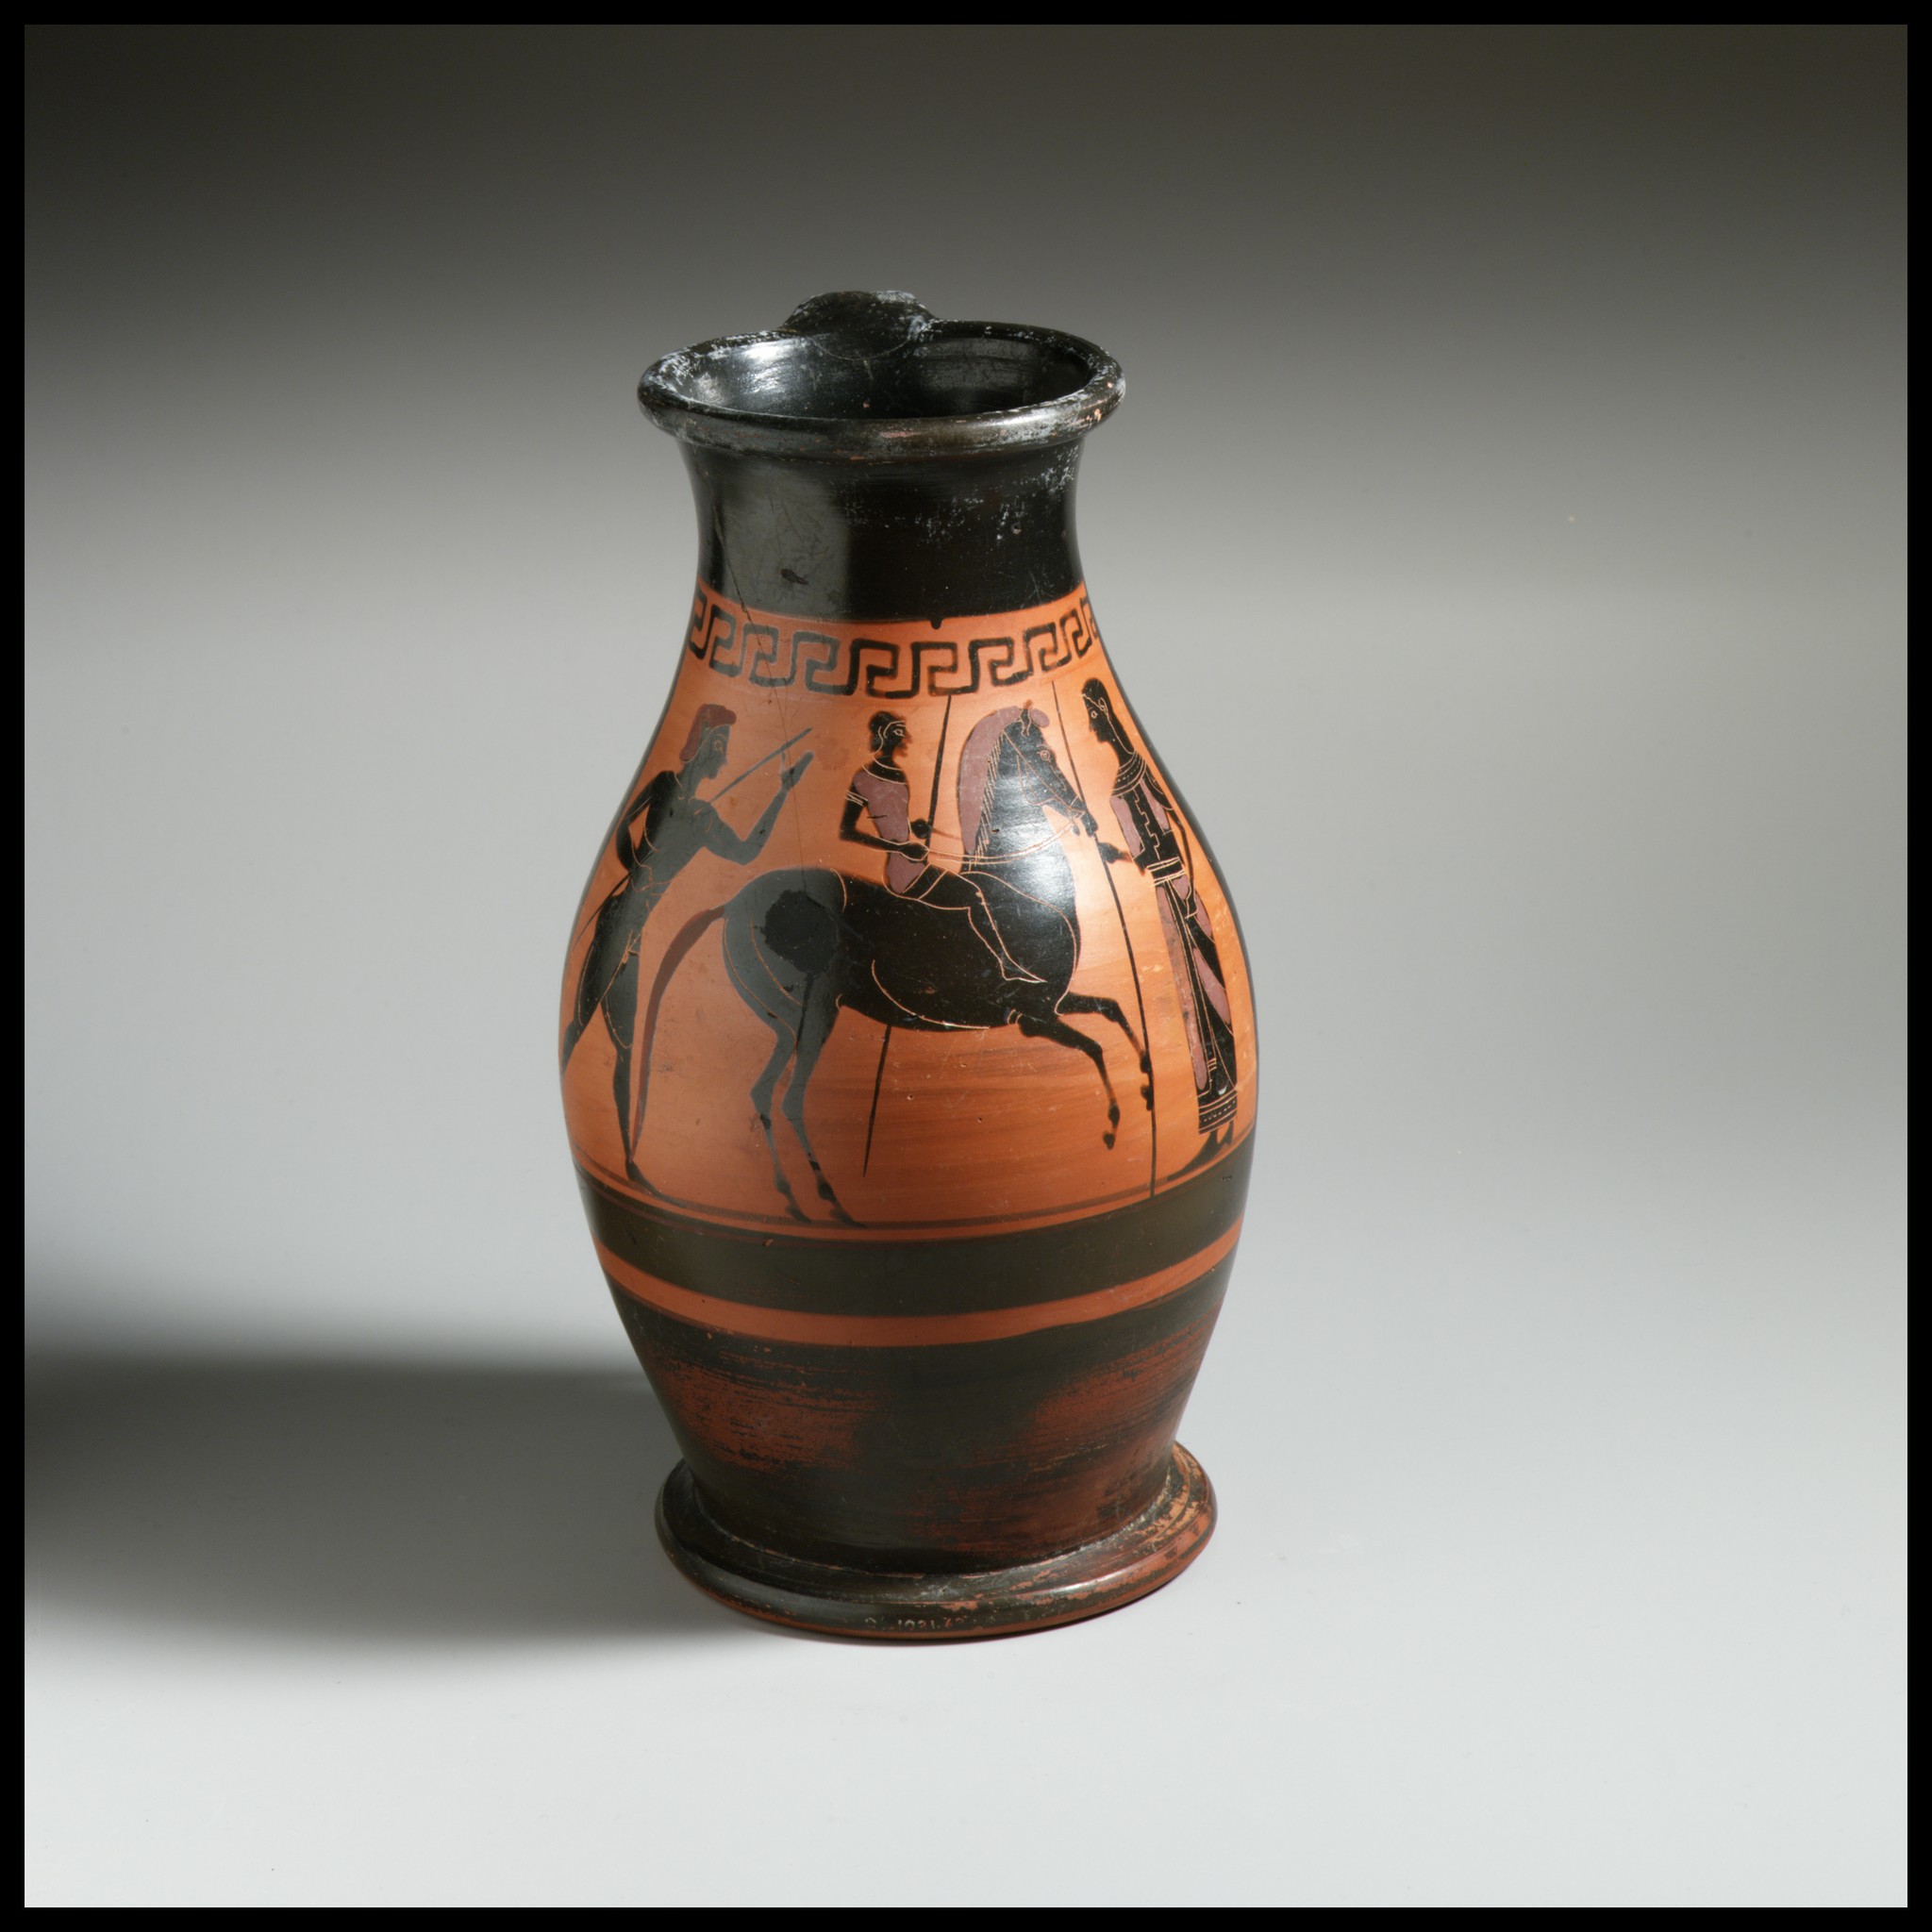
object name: olpe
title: Terracotta oinochoe: olpe (jug)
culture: greek, attic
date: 540 BCE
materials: terracotta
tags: spears,men,women,horses